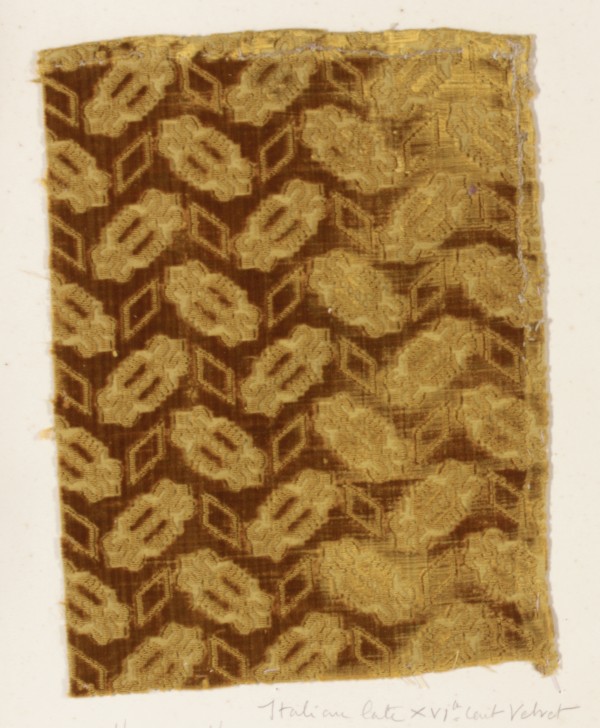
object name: fragment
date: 1501-1600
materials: silk